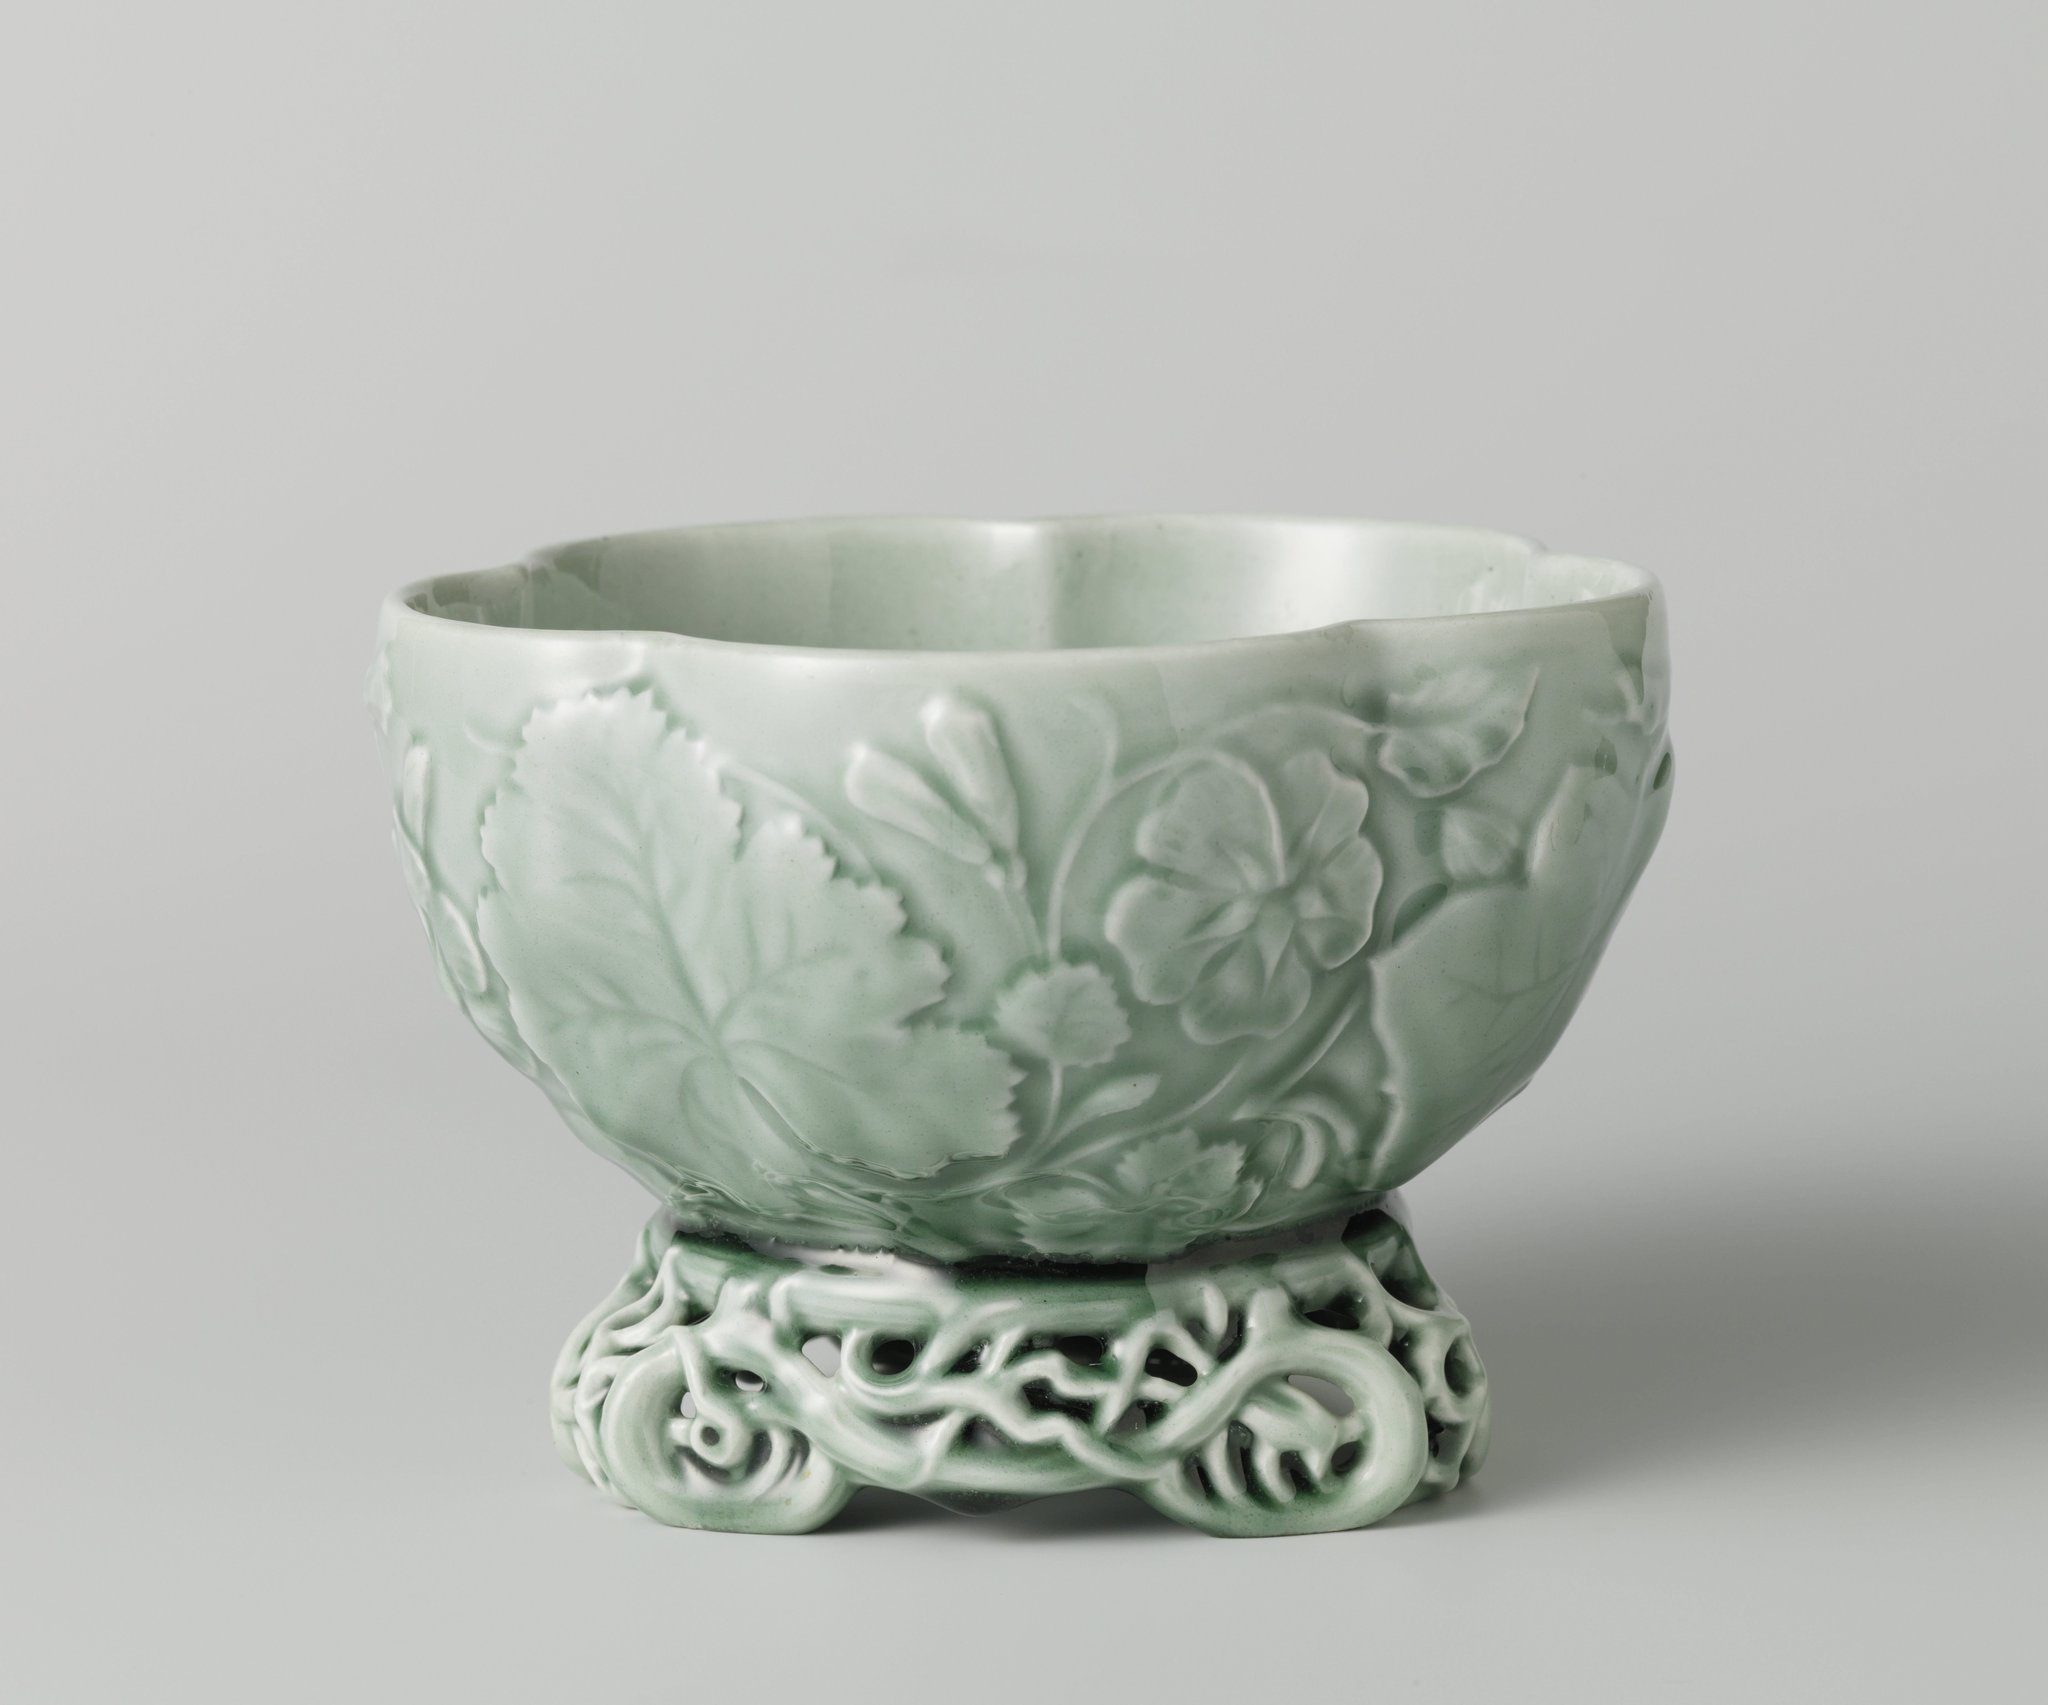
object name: bowl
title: Bowl on stand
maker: théodore deck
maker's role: ceramicist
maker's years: 1823-1891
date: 1890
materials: earthenware, glaze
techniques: firing, vitrification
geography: france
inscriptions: inscription: ‘Nagel’, mark: ‘TH(ineen). DECK/ XX’, inscription: ‘TH.L[...]/ PA[...]’, inscription: ‘735[...]’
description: Théodore Deck drew his inspiration for this bowl directly from the light-green celadon porcelain which had been made in Asia since the 9th century. In addition to imitating the colour, he also mimicked the incised leaf and flower motifs. Yet here these resemble the forms that actually occur in nature, in contrast to the stylised designs of early Asian celadon ware.